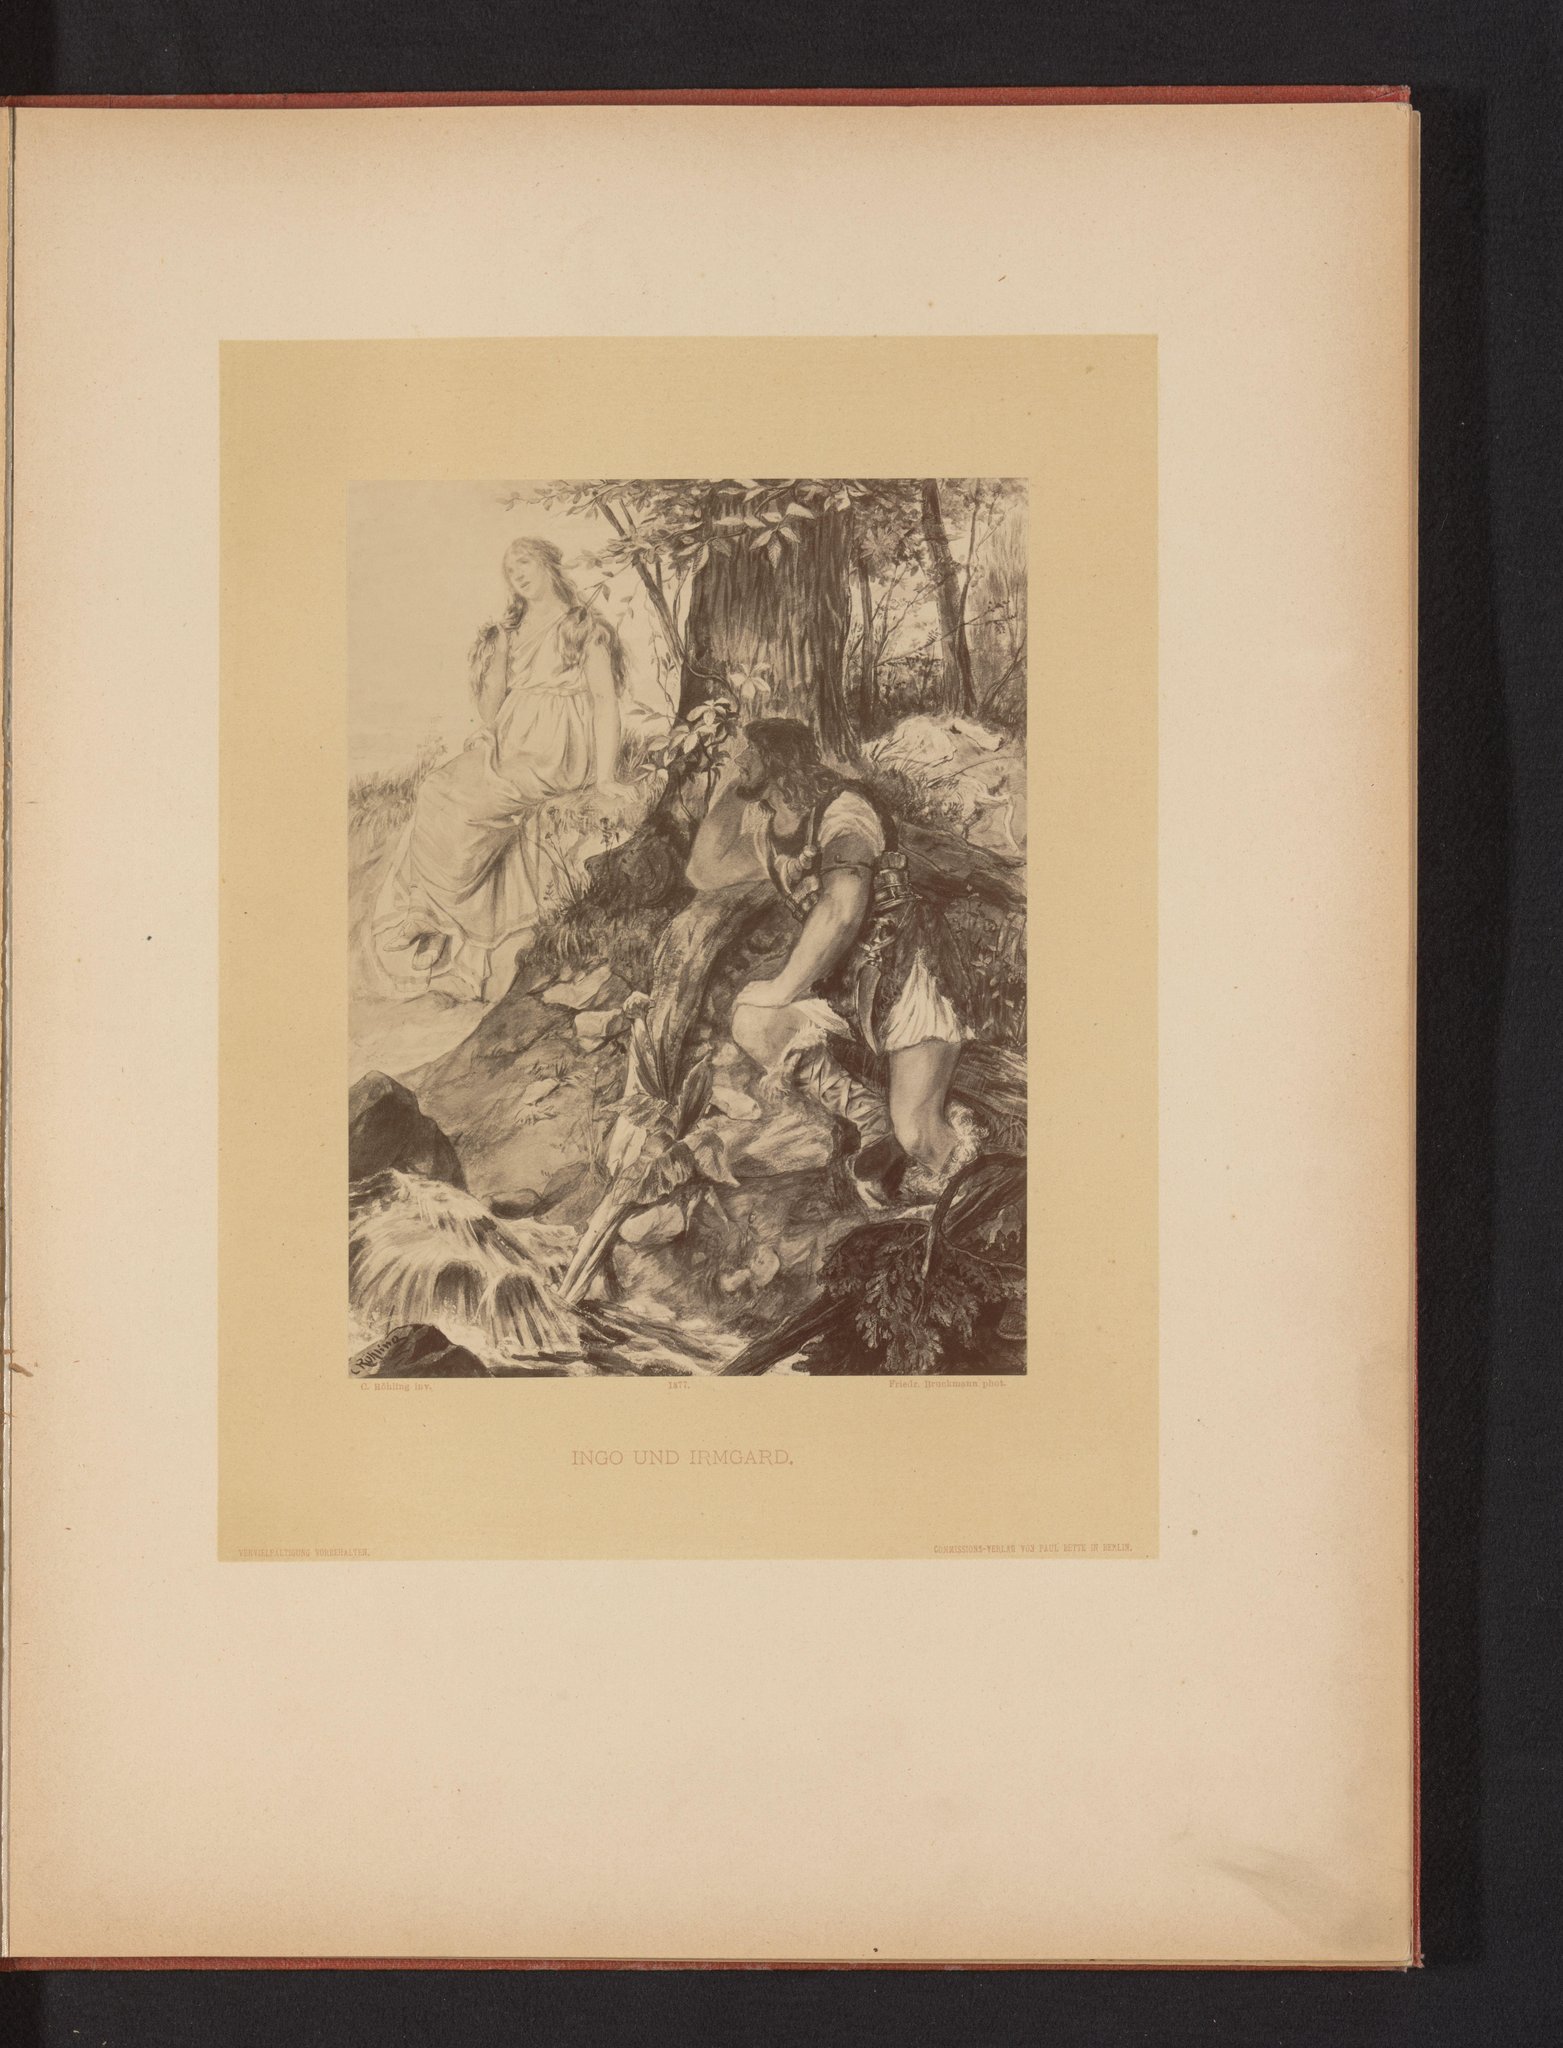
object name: photomechanical print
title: Ingo und Irmgard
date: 1877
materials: paper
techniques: woodburytype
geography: berlin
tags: adult woman, adult man, specific works of literature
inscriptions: inscription: ‘VERVIELFÄLTIGUNG VORBEHALTEN.’